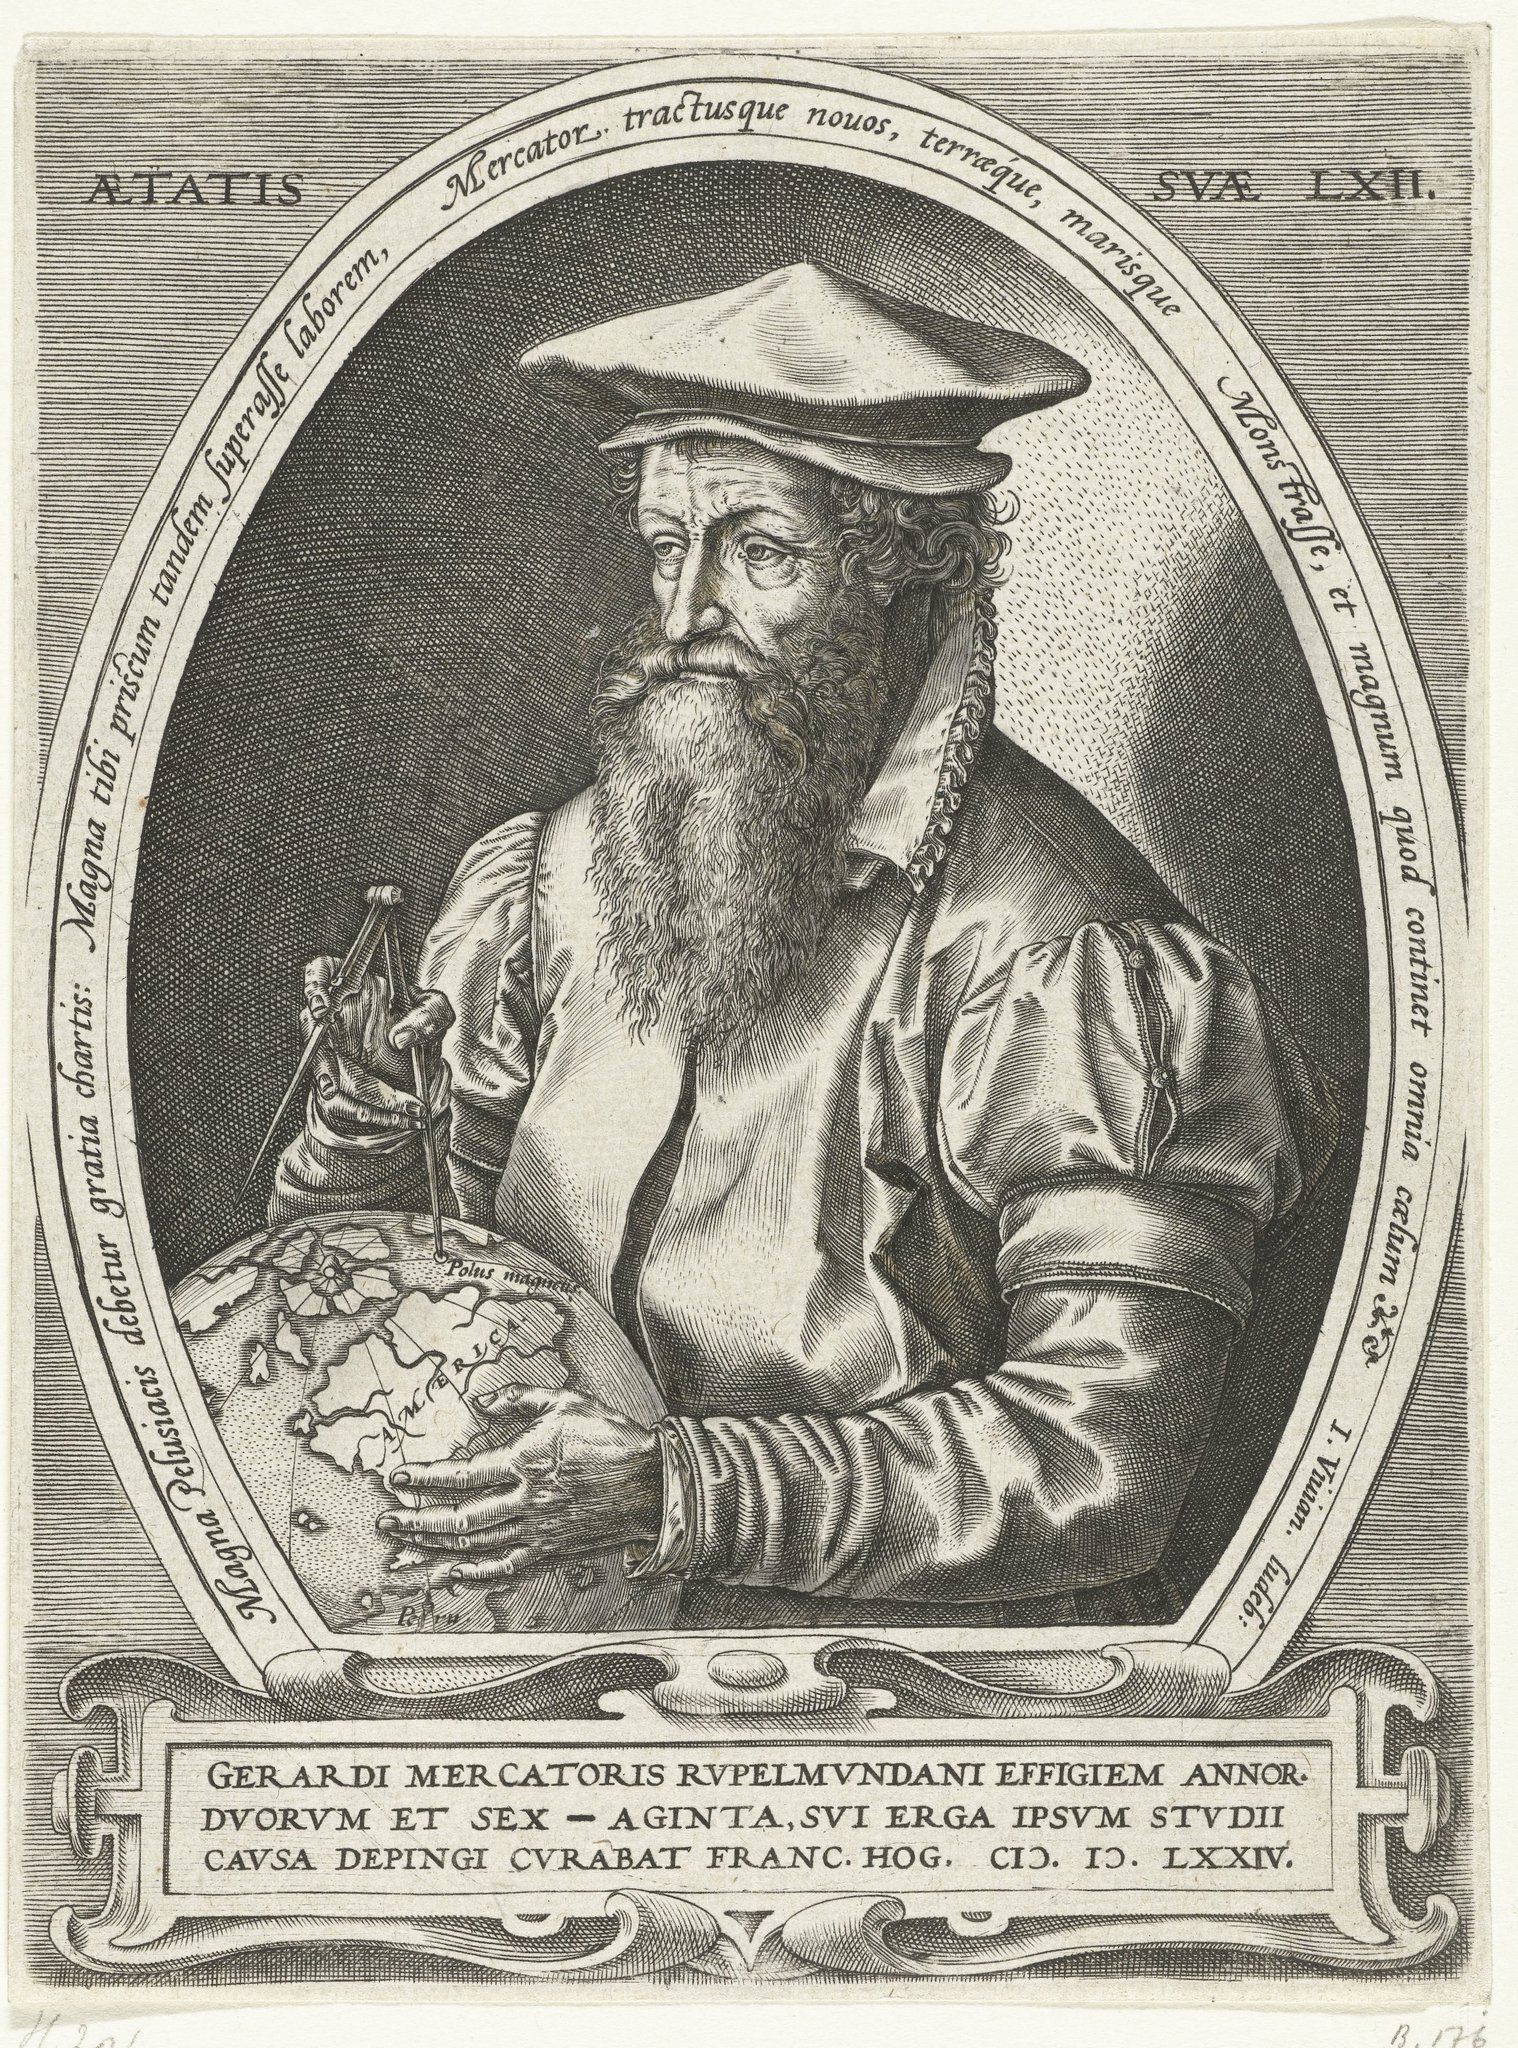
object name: print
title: Portret van Gerardus Mercator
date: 1574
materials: paper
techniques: engraving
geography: haarlem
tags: instrument maker, gerardus mercator, historical persons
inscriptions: collector's mark: Lugt 2228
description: In de eerste staat is Mercator 72 jaar. Als deze leeftijd correct is, klopt de datering (1576) niet. In de tweede staat is de leeftijd gecorrigeerd in 64 en blijft de datering onveranderd. In de derde staat is Mercator twee jaar jonger geworden (62) en is de datering aangepast tot 1574. Er bestaat twijfel of dit portret van Mercator daadwerkelijk van Goltzius' hand is (zie documentatie: Leeflang 2003). Jacobs, G.